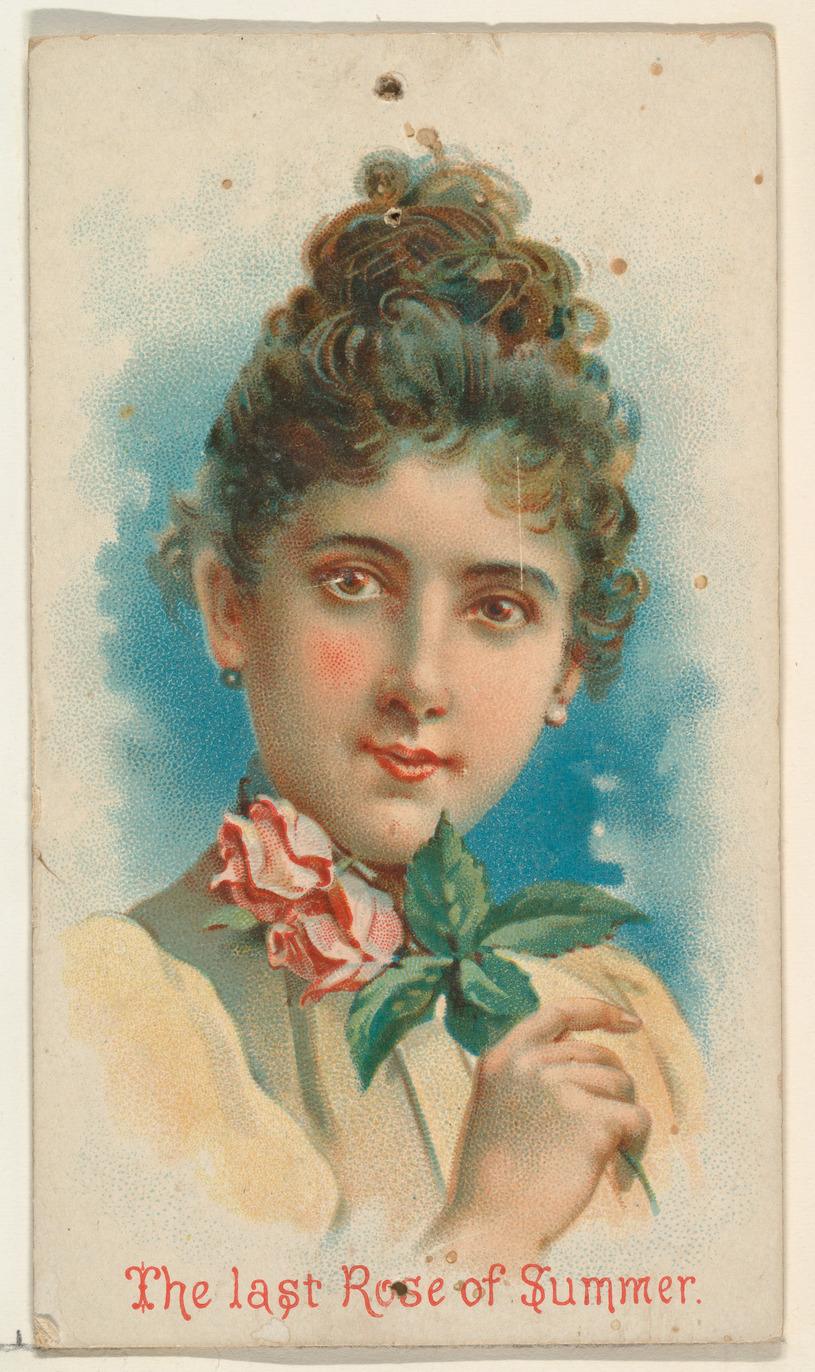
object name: print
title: The Last Rose of Summer, from the Illustrated Songs series (N116) issued by W. Duke, Sons & Co. to promote Honest Long Cut Tobacco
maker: w. duke, sons & co.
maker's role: publisher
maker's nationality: american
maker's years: 1870-1920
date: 1893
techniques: color lithograph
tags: women,roses